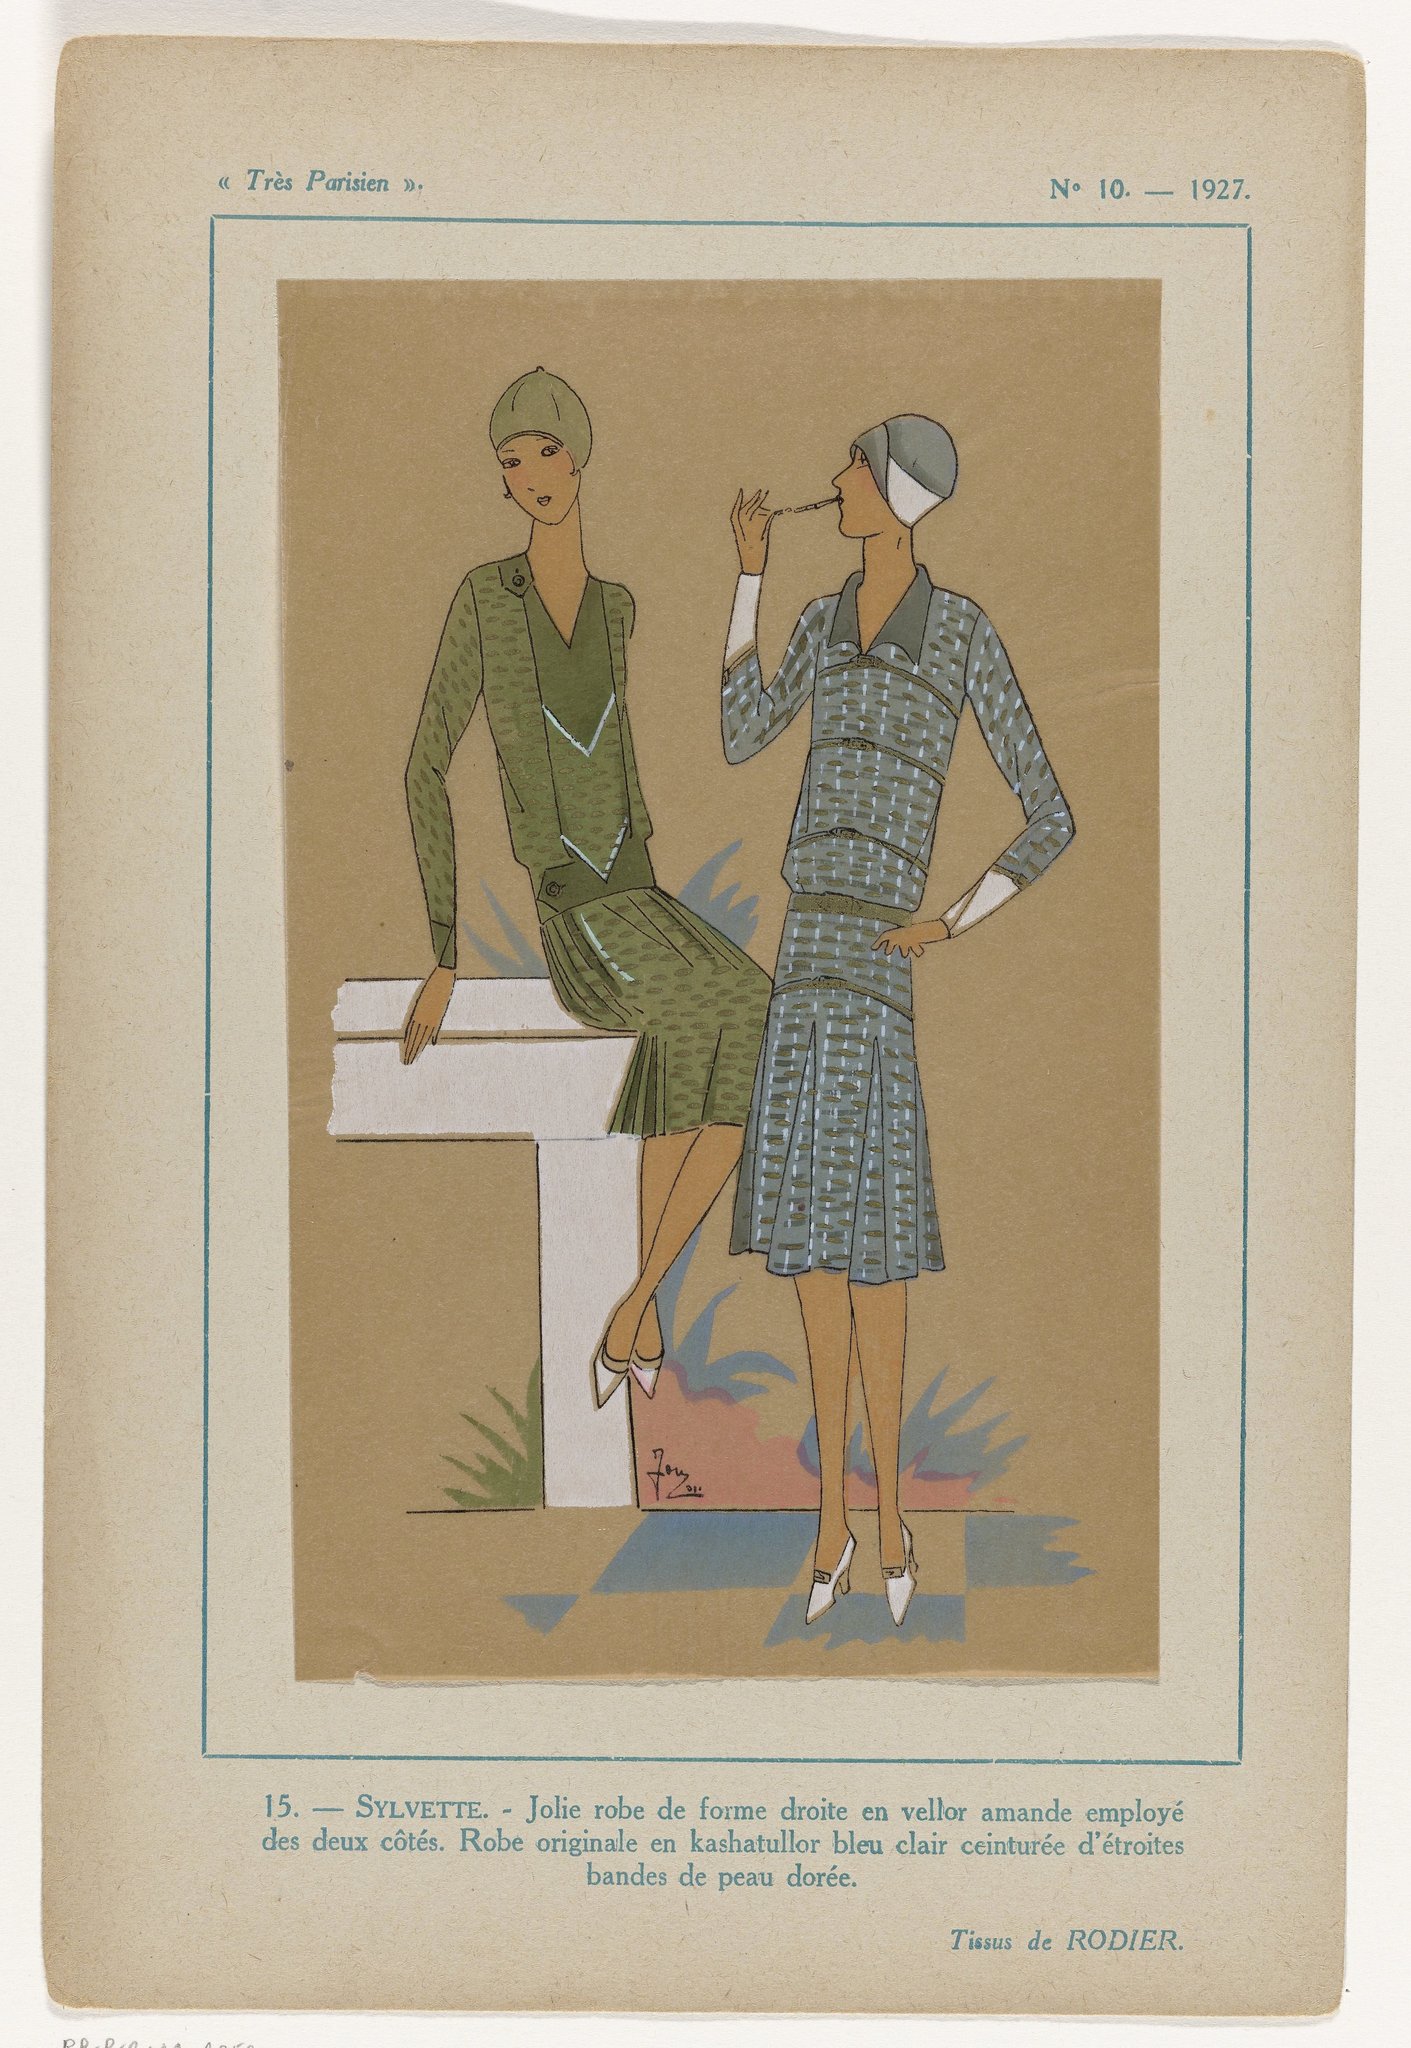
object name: fashion print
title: Très Parisien, 1927, No. 10 : 15.-Sylvette.-Jolie robe de form (...)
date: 1927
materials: paper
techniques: hand coloring, letterpress printing, lithography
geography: paris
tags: border, ribbon, braid (+ leather used for clothes), cigarette-tube, cigarette-holder (+ taking (particular) foodstuffs: eating, drinking, smoking, chewing, etc.), fashion plates, dress, gown (+ women's clothes)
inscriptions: title: ‘"Très Parisien" / No 10. - 1927’, caption: ‘15. - SYLVETTE. - Jolie robe de forme droite en vellor amande employé des deux côtés. Robe originale en kashatullor bleu clair ceinturée d'étroites bandes de peau dorée. / Tissus de RODIER.’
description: Jurk, recht model, van amandelkleurige 'vellor'. Jurk van lichtblauwe 'kashatullor' met dunne banden van goudkleurig leer. Stoffen van Rodier. Accessoires: cloche (pothoed), pumps. Prent uit het modetijdschrift Très Parisien (1920-1936).